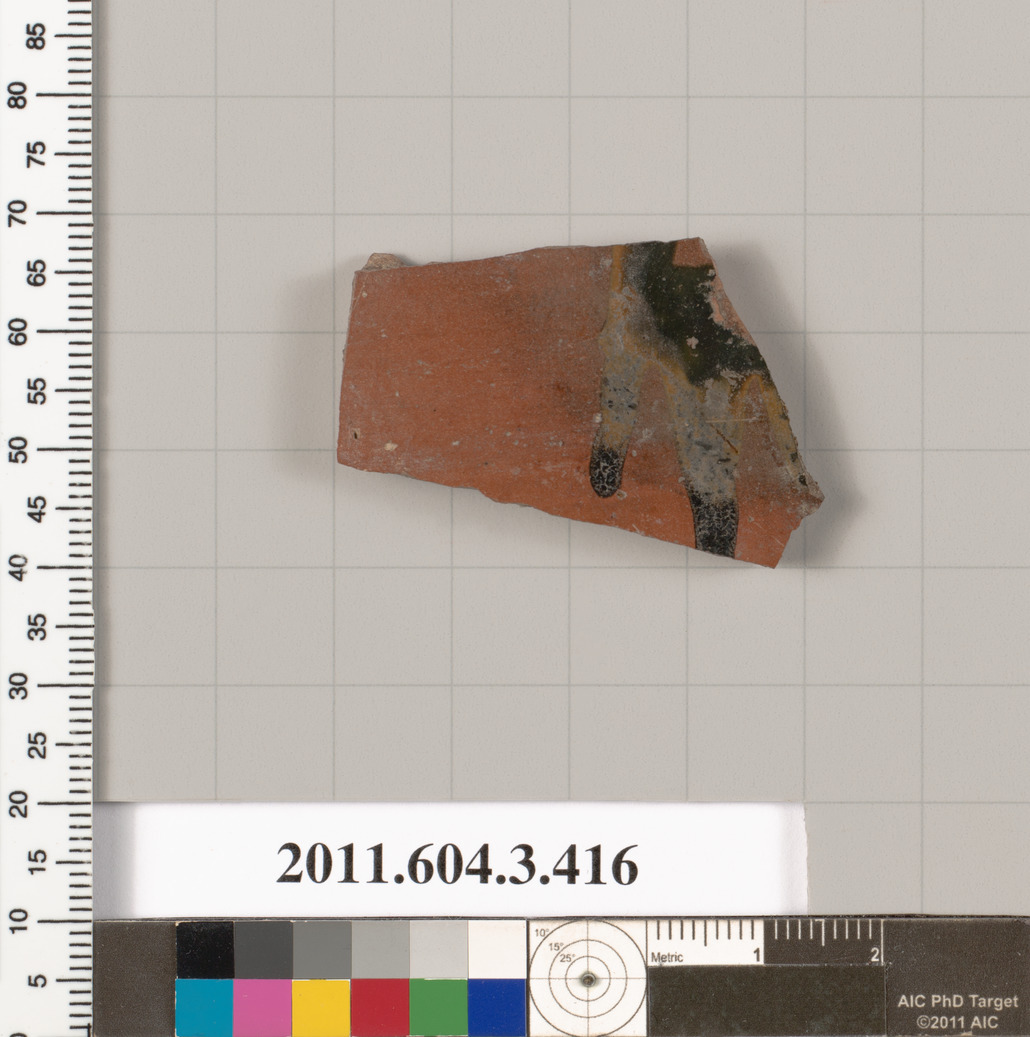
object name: neck amphora fragment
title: Terracotta fragment of a neck-amphora (jar)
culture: greek, attic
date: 525-501 BCE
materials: terracotta